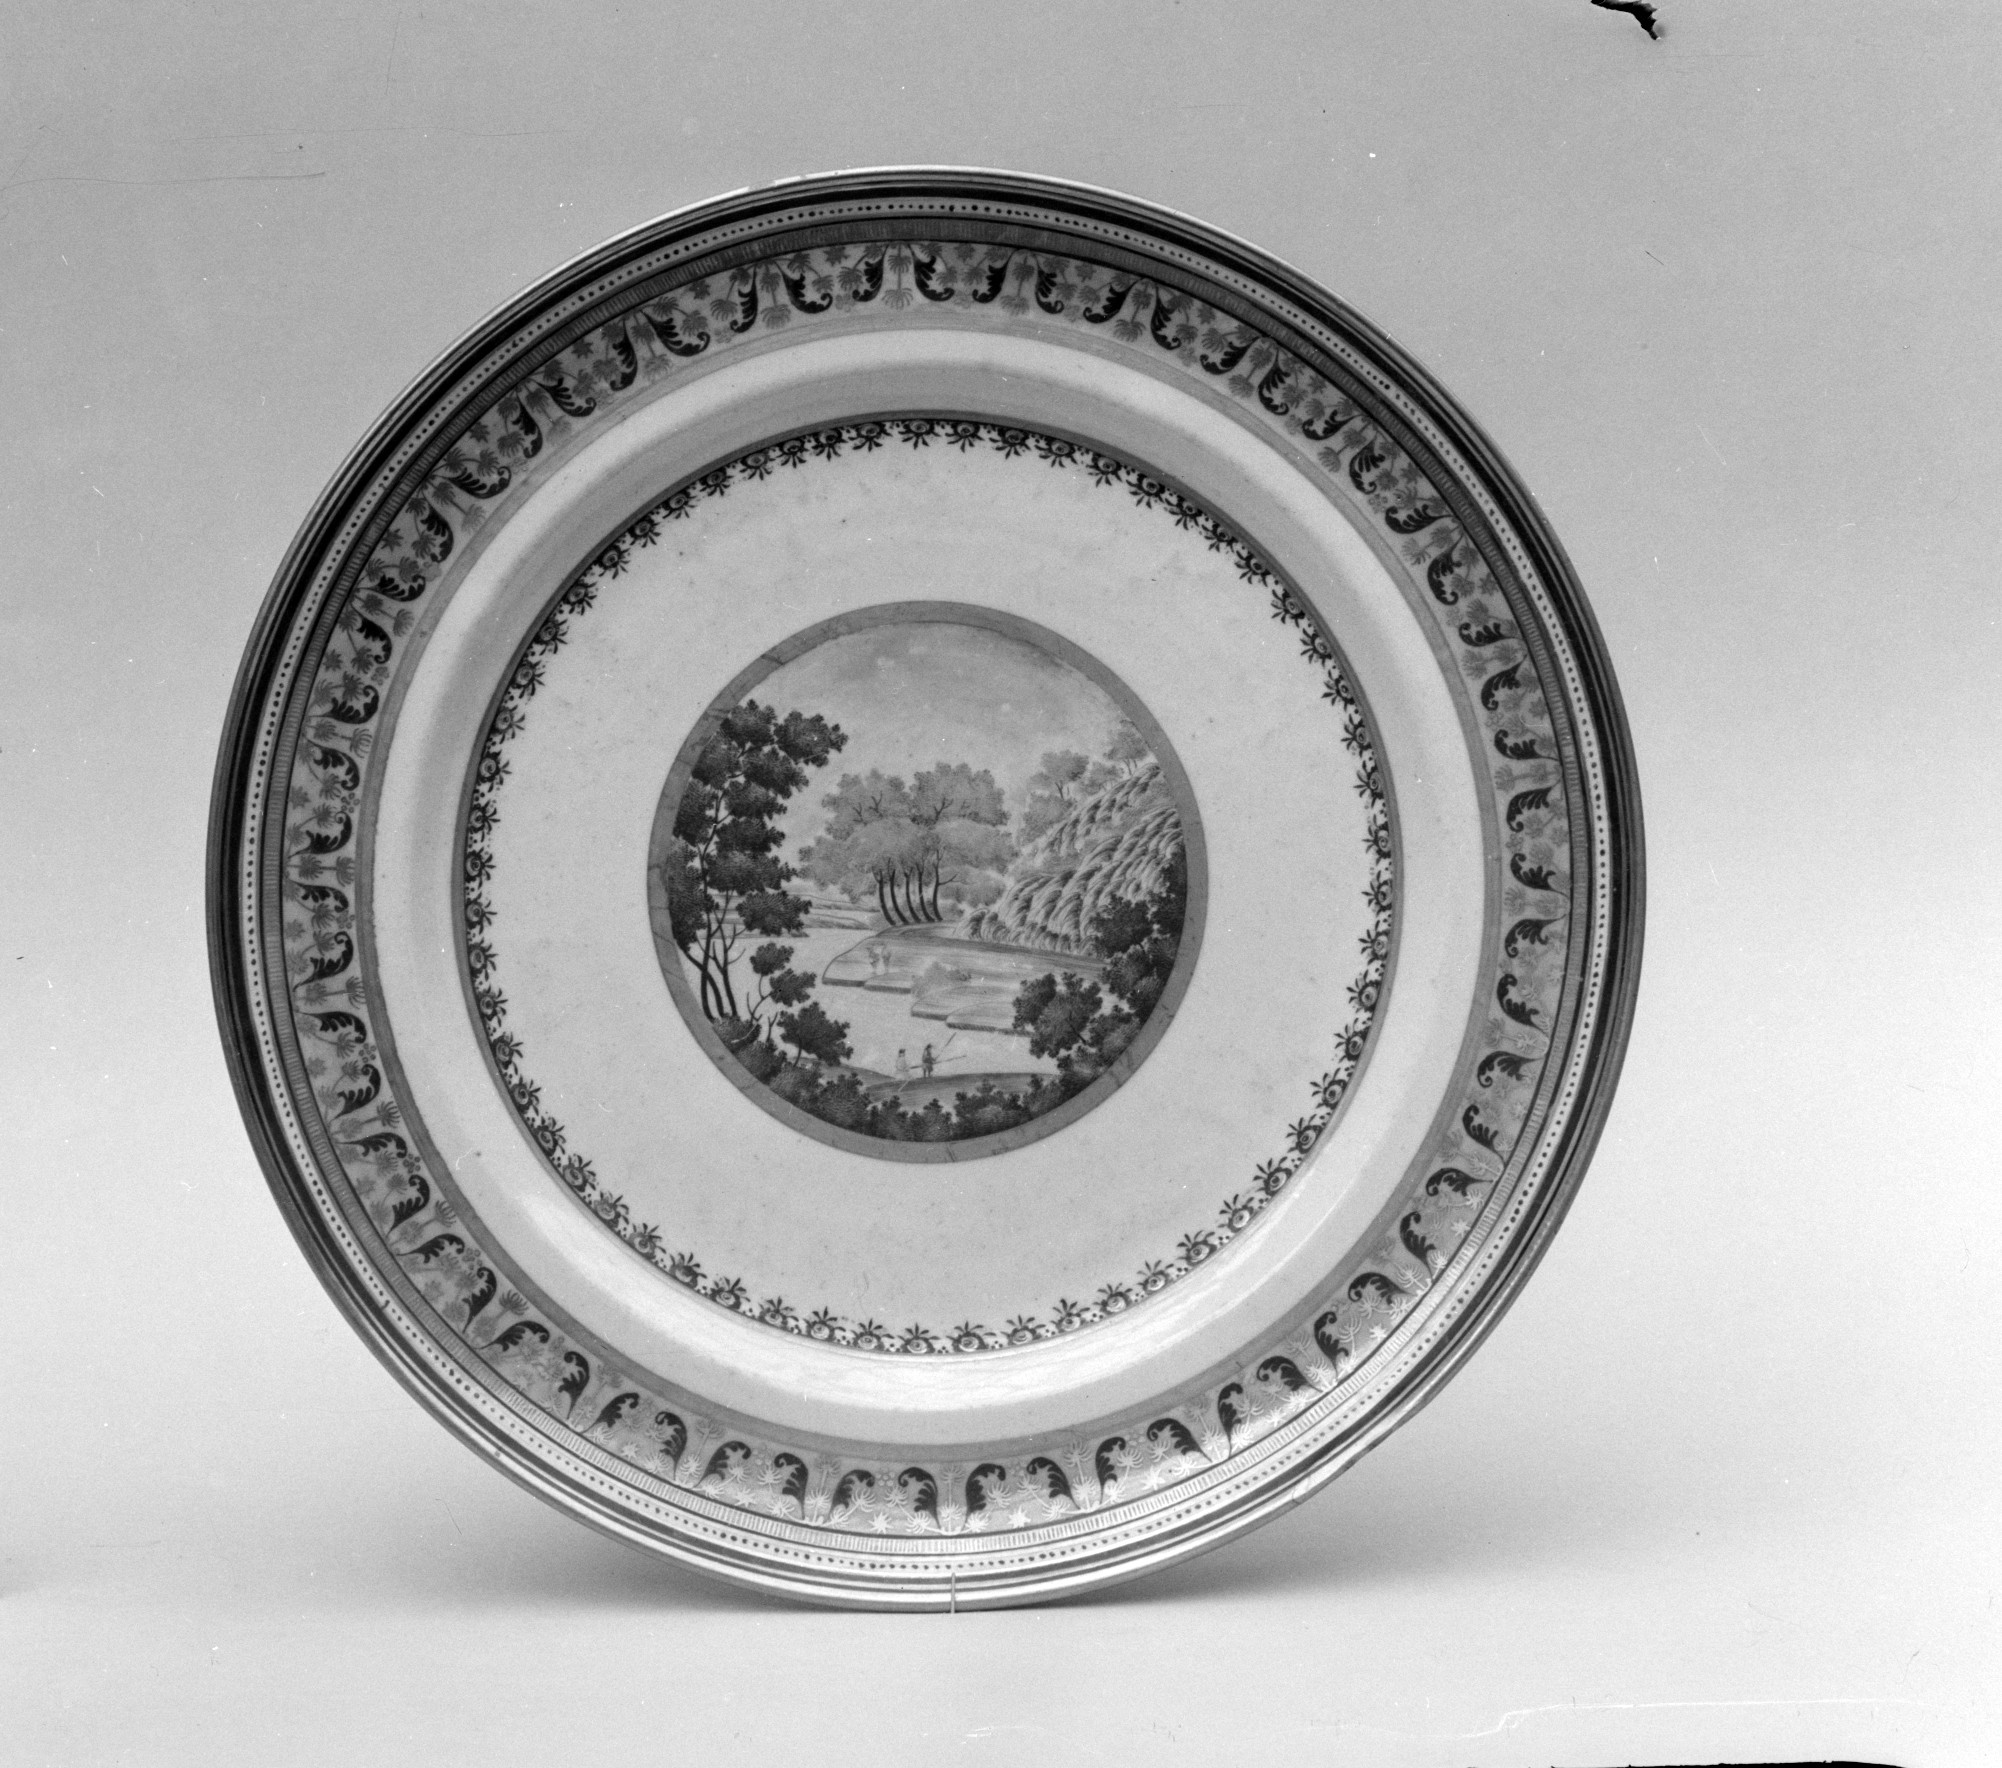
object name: plate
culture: chinese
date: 1800-1830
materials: porcelain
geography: china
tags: landscapes